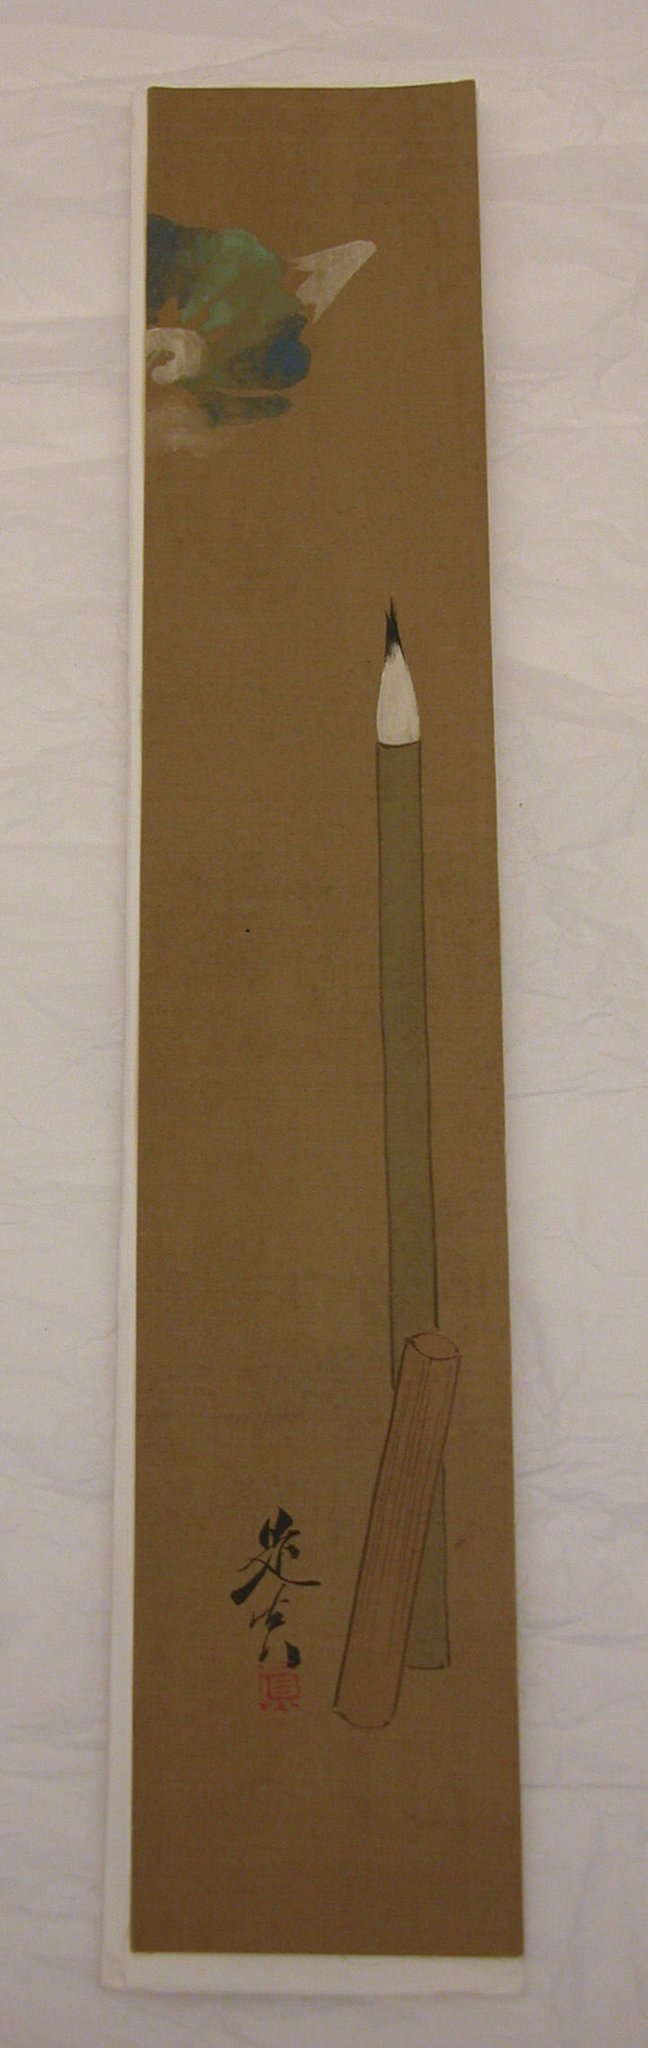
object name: painting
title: Brush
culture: japanese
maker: shibata zeshin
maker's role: artist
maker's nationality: japanese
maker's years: 1807-1891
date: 1801-1900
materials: ink, paper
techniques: painting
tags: brushes